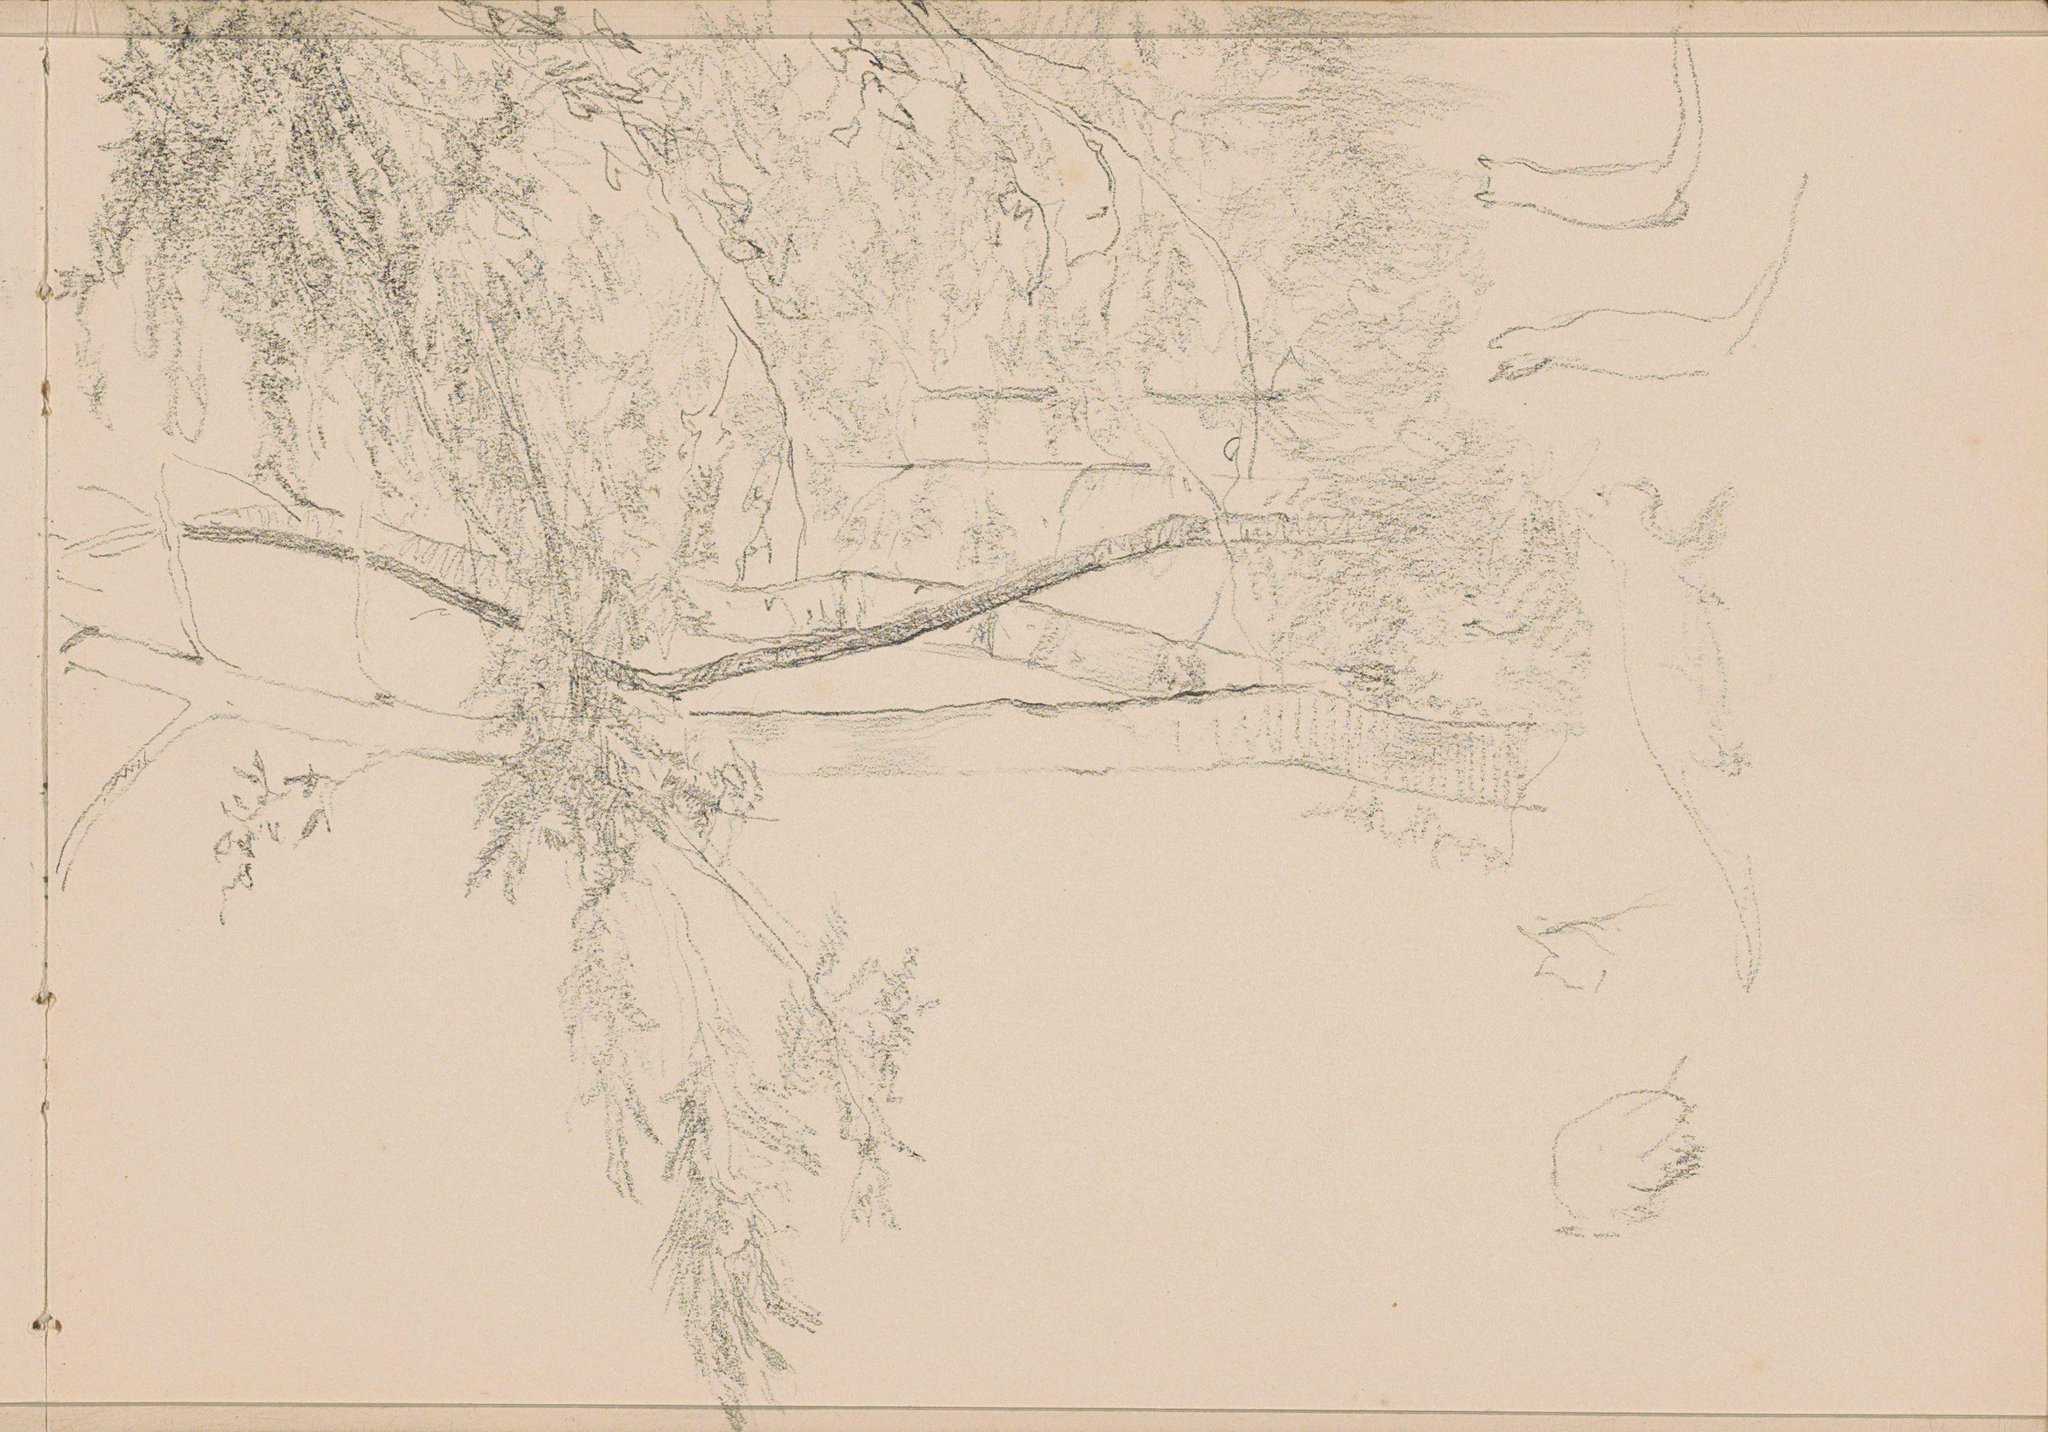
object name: sketchbook leaf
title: Vossen bij een groep bomen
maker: a.a.l. de grammont-hubrecht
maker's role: draughtsman, painter, print maker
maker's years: 1855-1913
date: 1865-1913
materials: chalk, paper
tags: trees, beasts of prey, predatory animals: fox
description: Blad 18 recto uit een schetsboek met 68 bladen.